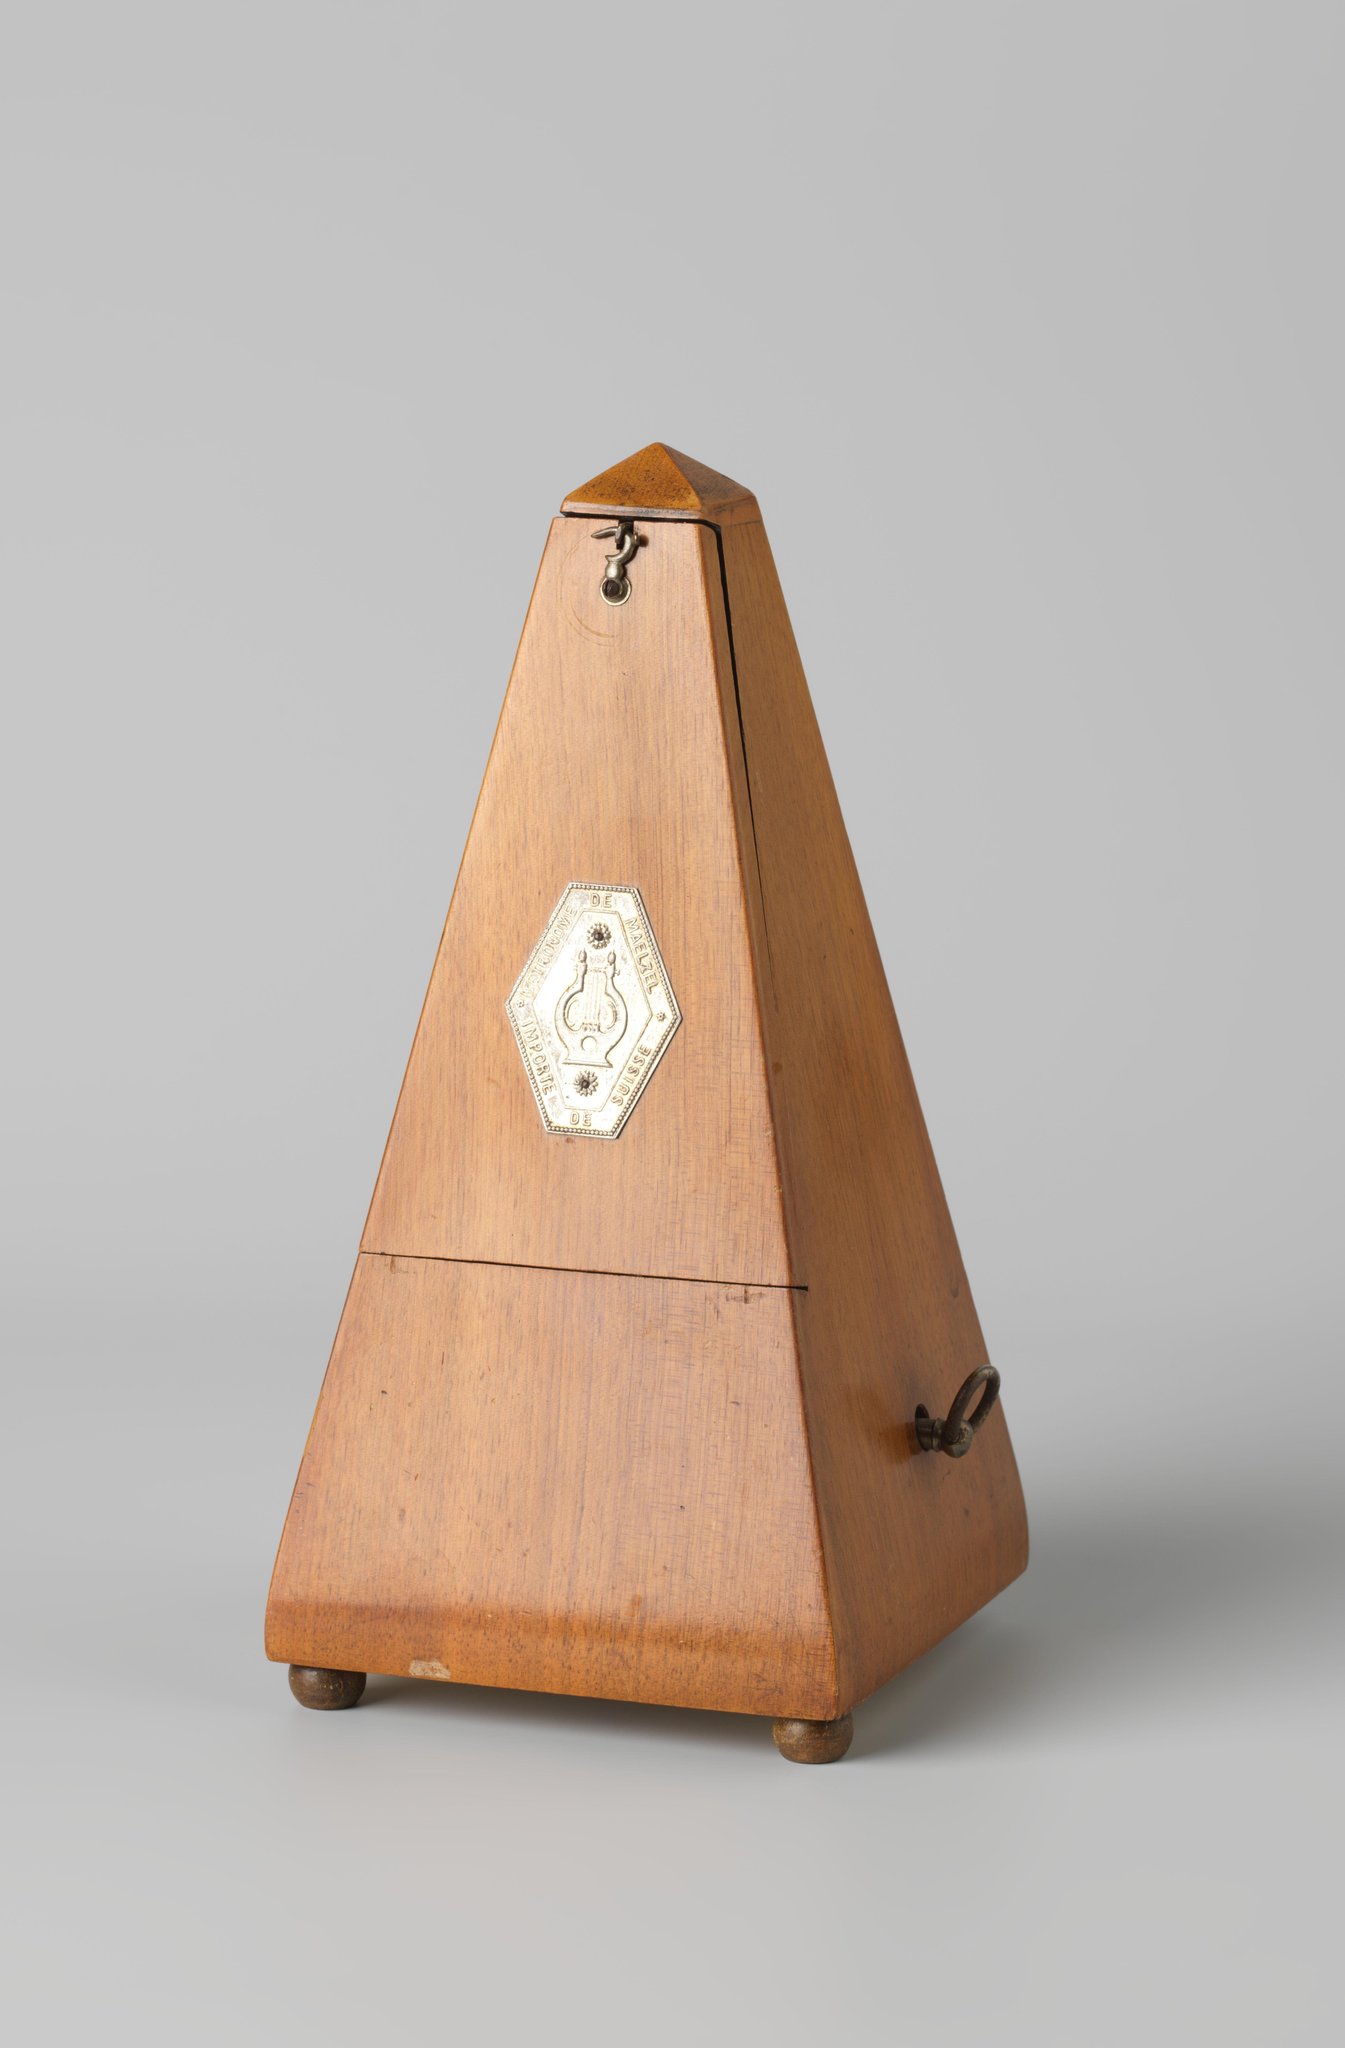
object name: metronome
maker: johann nepomuk maelzel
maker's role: musicus, uitvinder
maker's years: 1772-1838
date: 1880-1900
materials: iron, wood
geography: london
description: Metronoom met vurenhouten kist. Adres: I. MAELZEL'S CHRONOMETER LONDON.